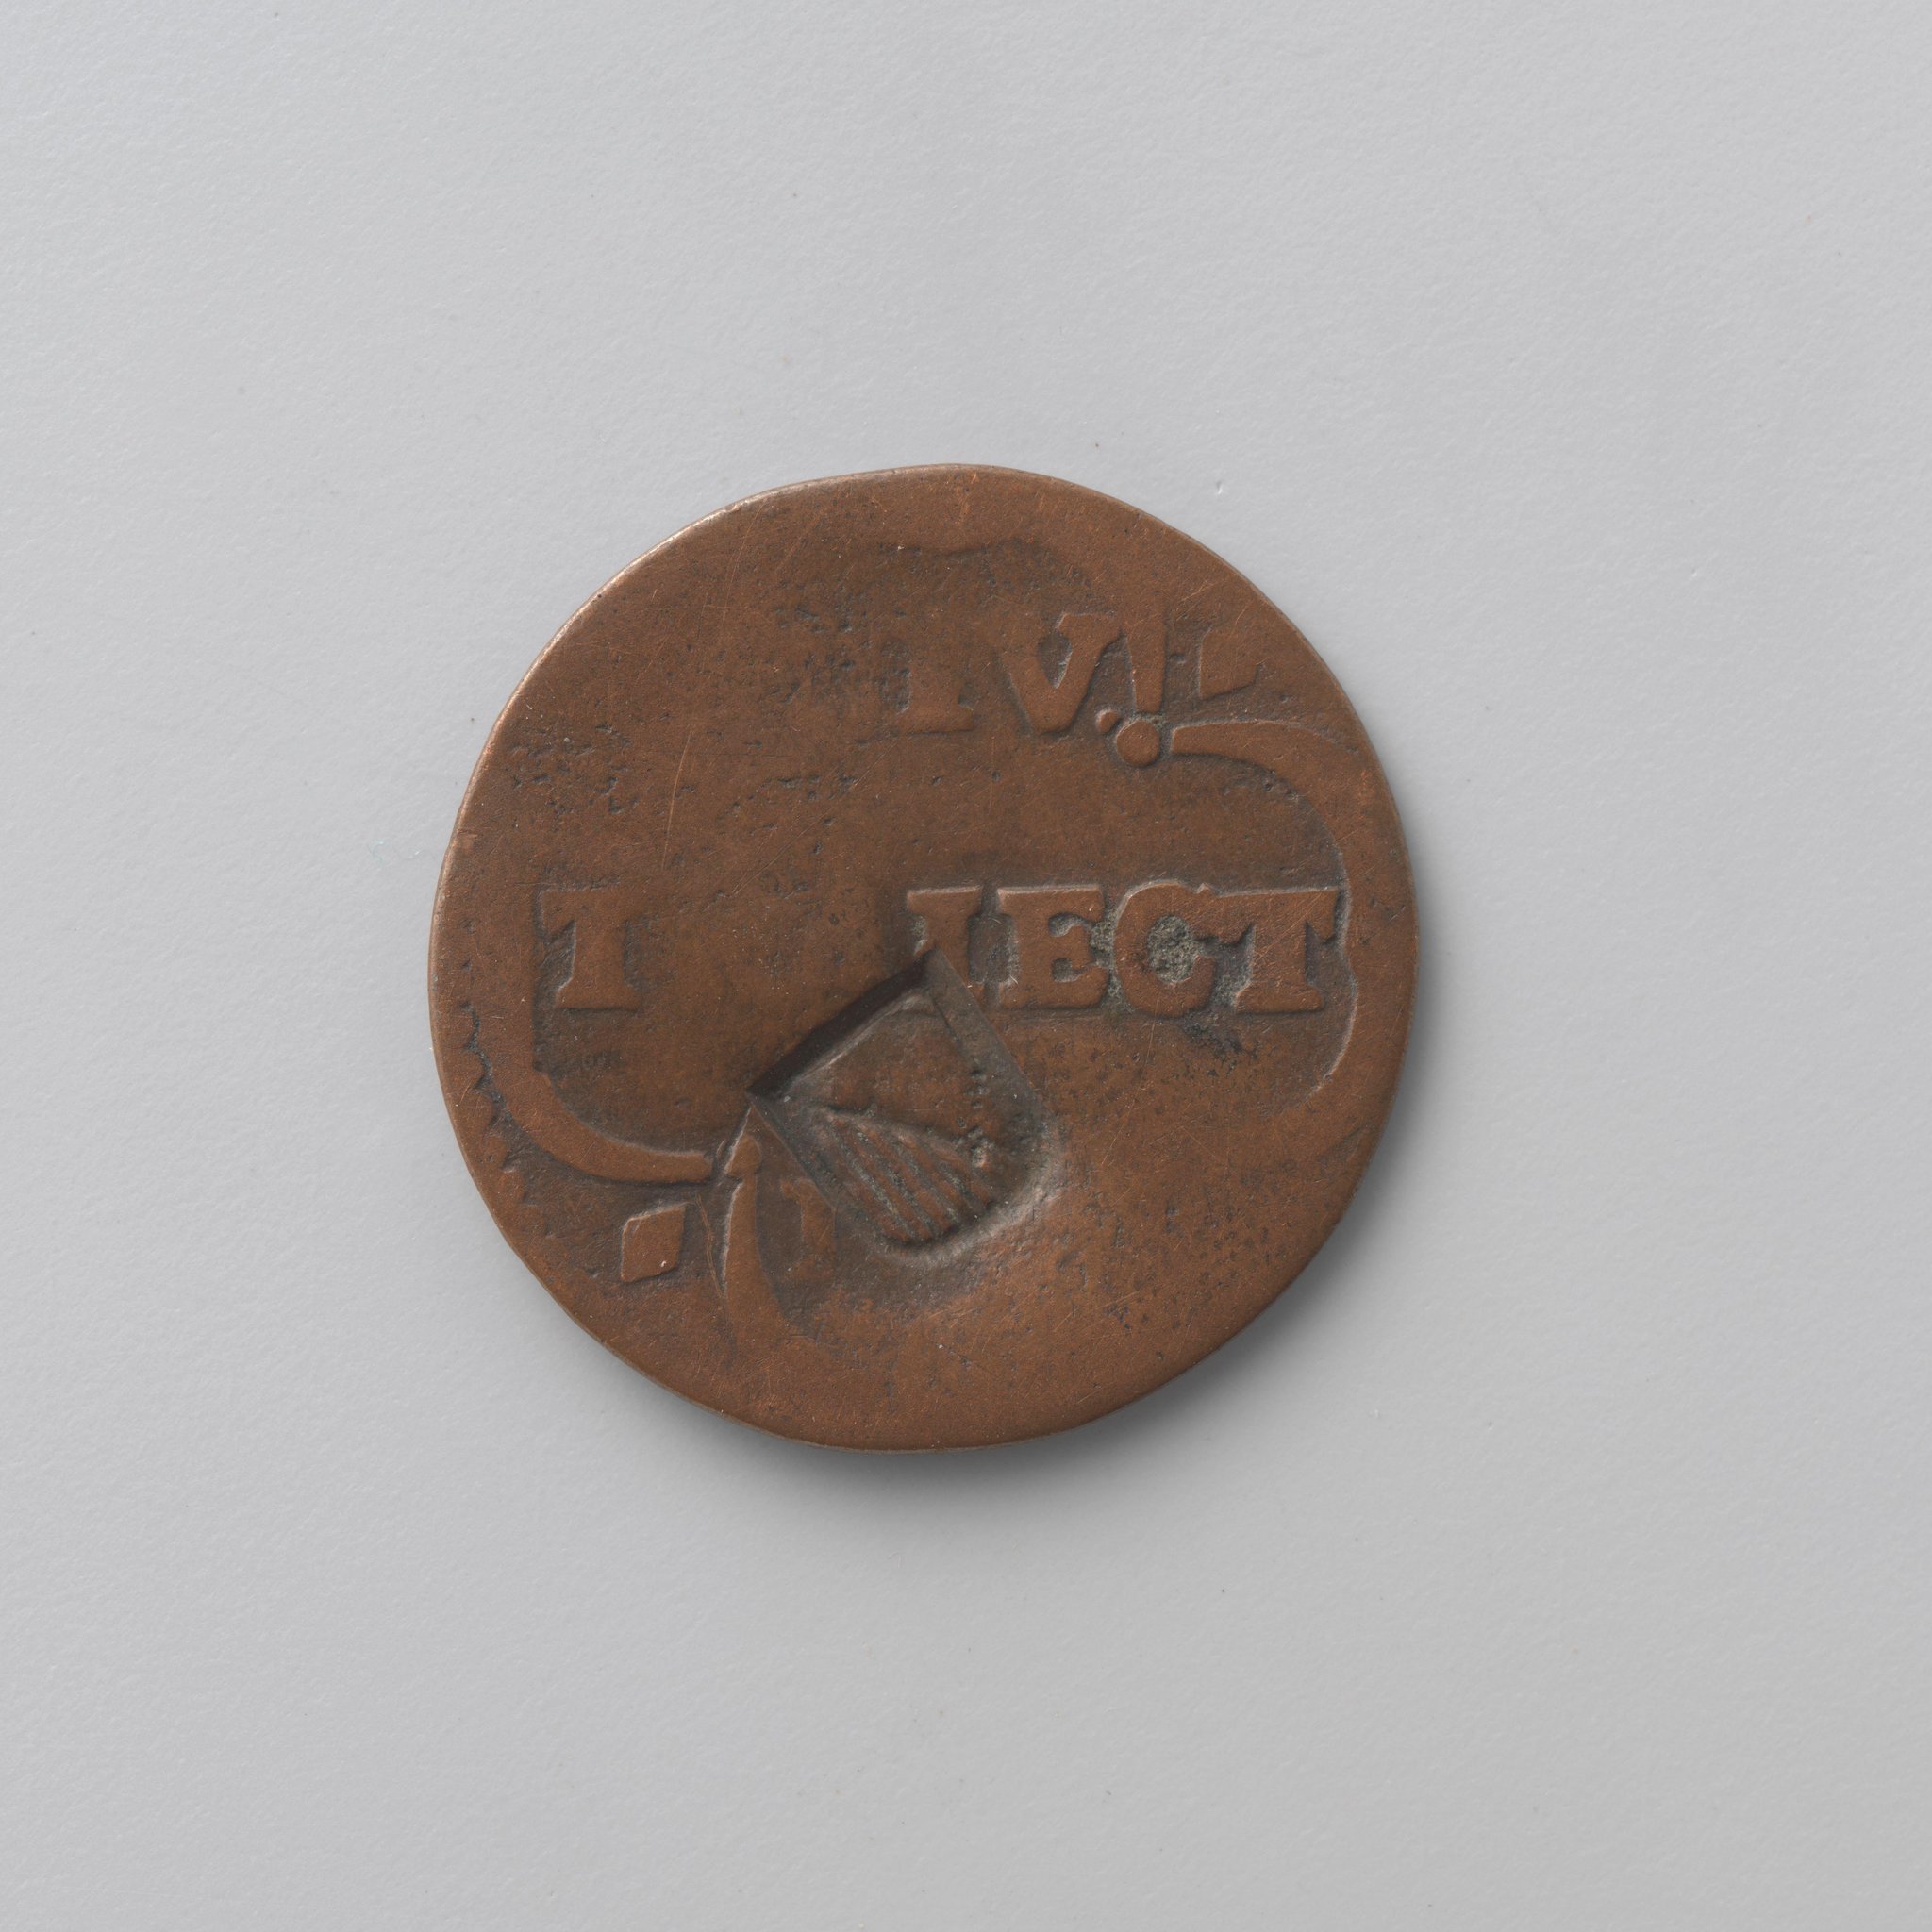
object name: coin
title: Stad Utrecht, duit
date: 1657-1689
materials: copper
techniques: striking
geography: utrecht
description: Koperen munt. Voorzijde: gekroond stedelijk wapenschild, gehouden door twee leeuwen. Keerzijde: binnen een versierde vierpas opschrift in twee regels, waaronder jaartal. Op voorzijde klop van stad Utrecht.